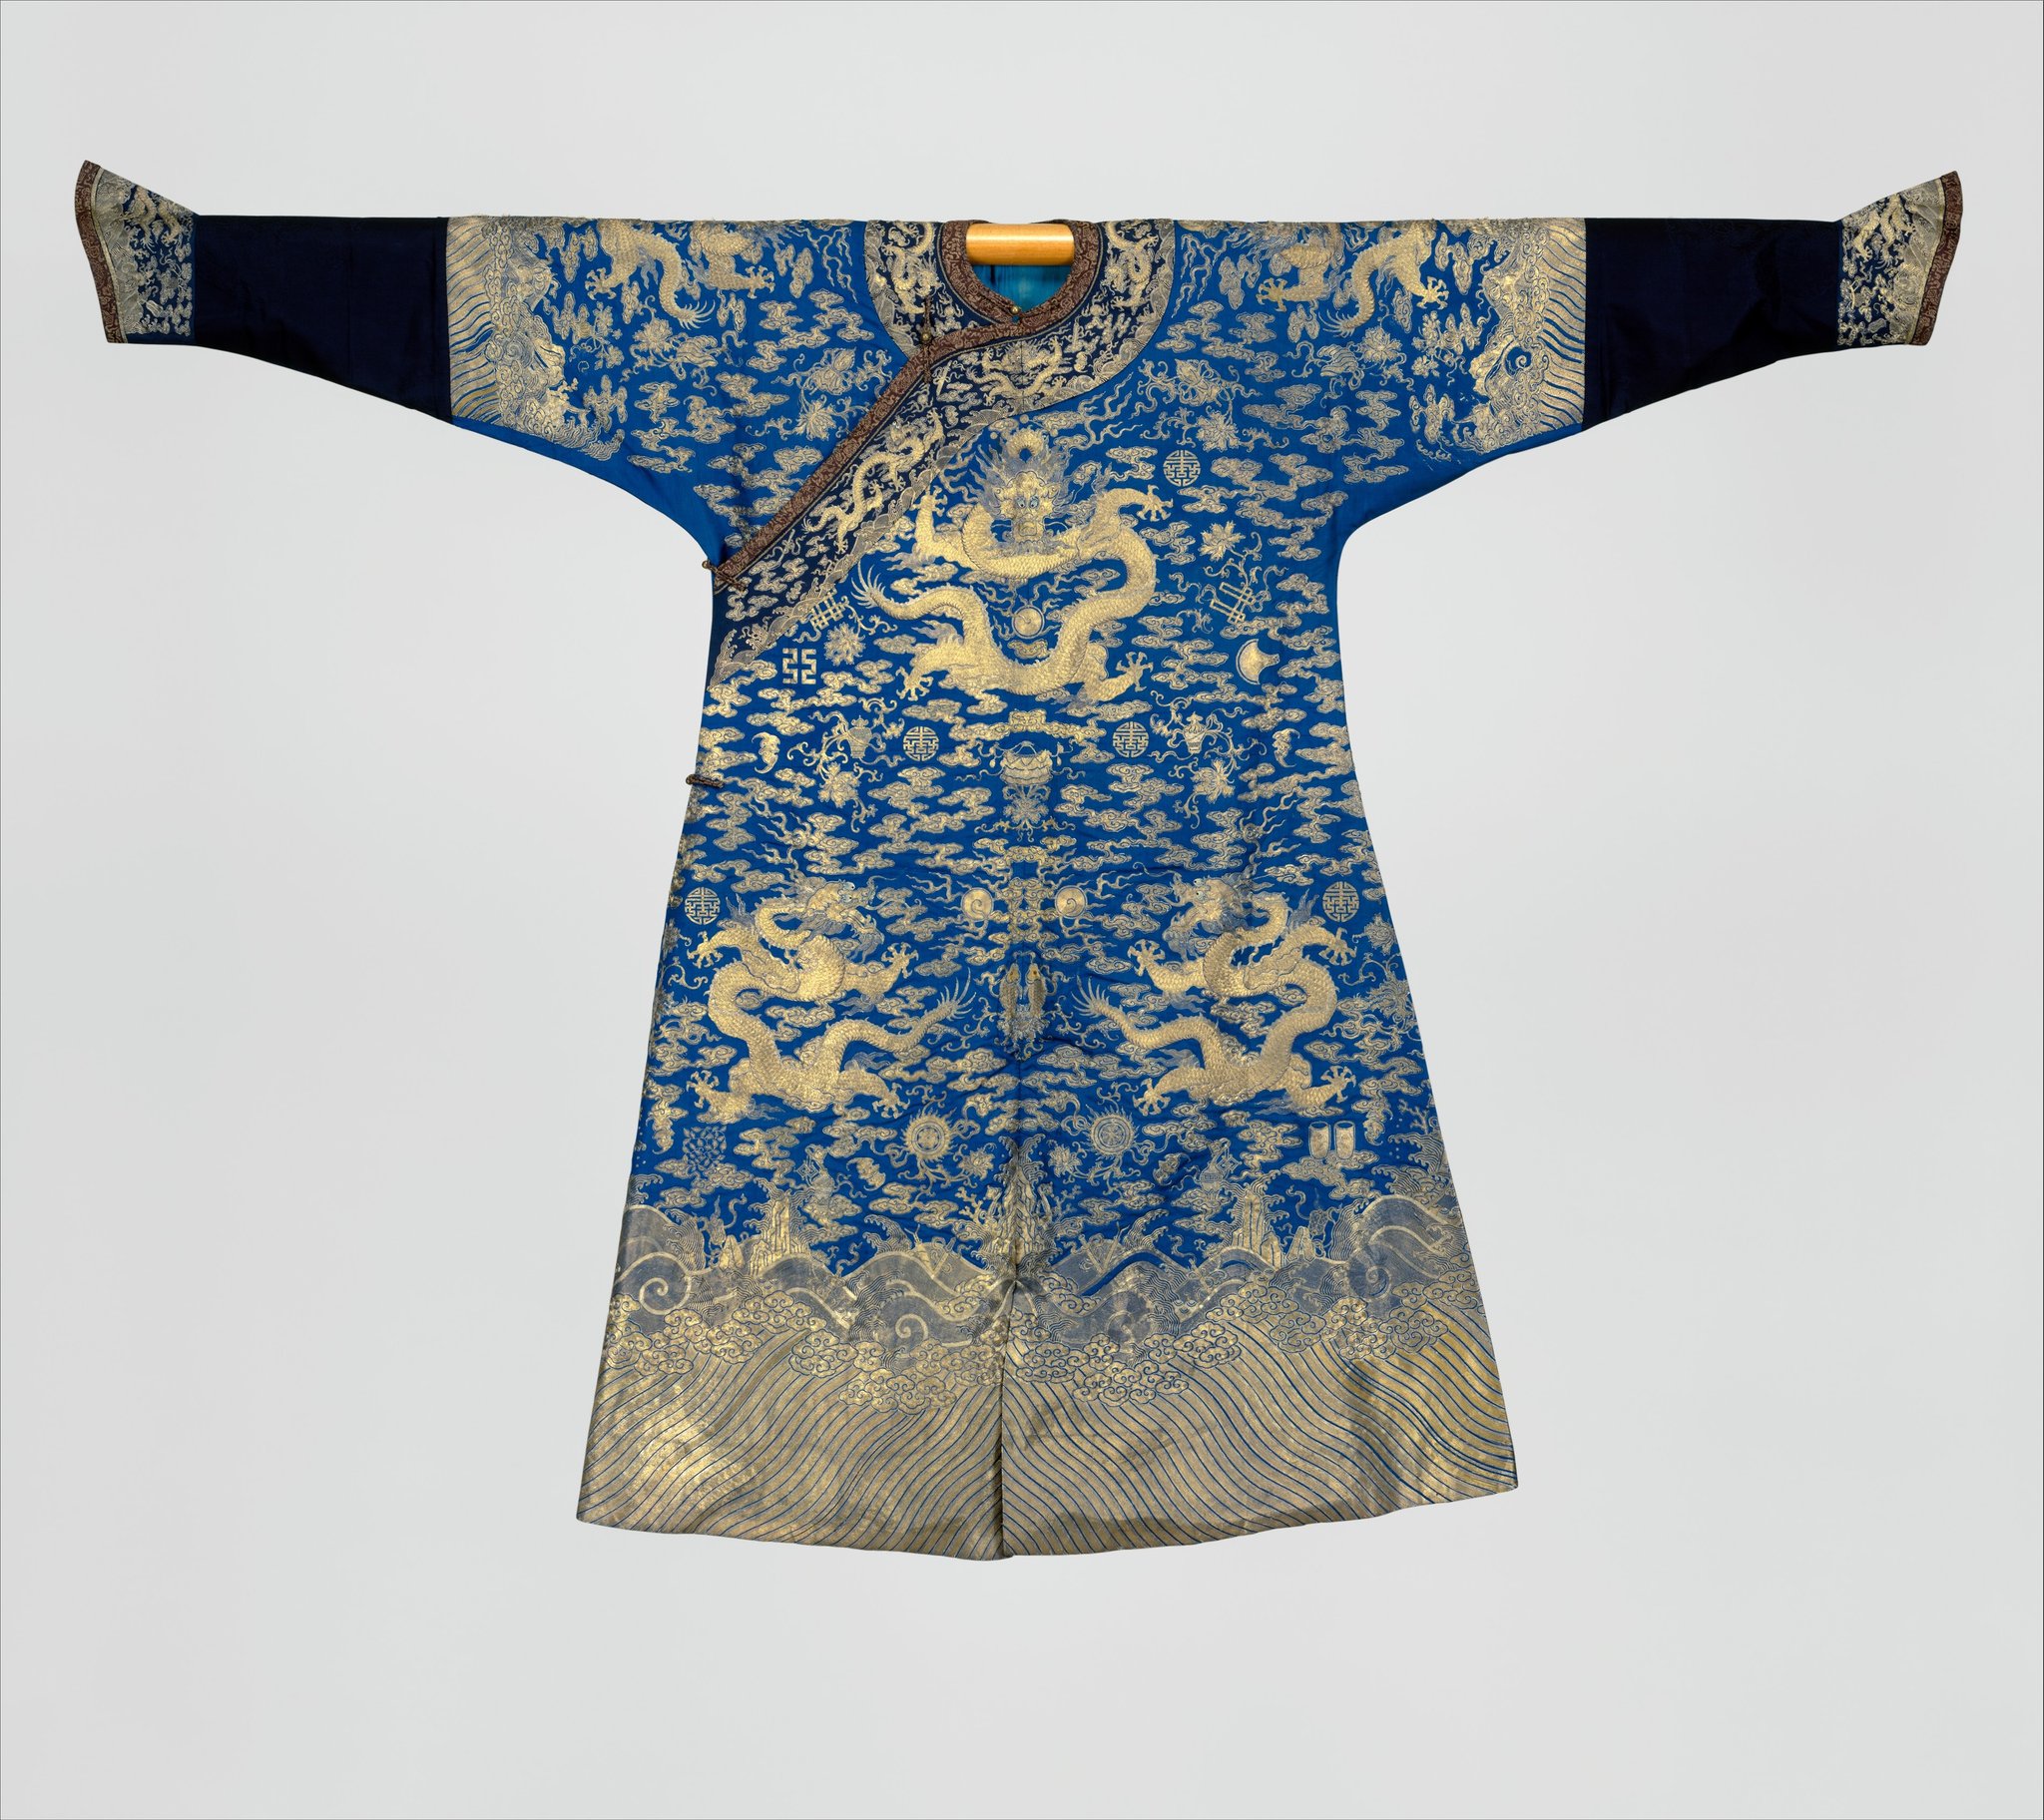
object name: robe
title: Emperor’s twelve-symbol festival robe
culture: chinese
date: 1736-1795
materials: gold, silk, thread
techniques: embroidery, weave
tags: dragons